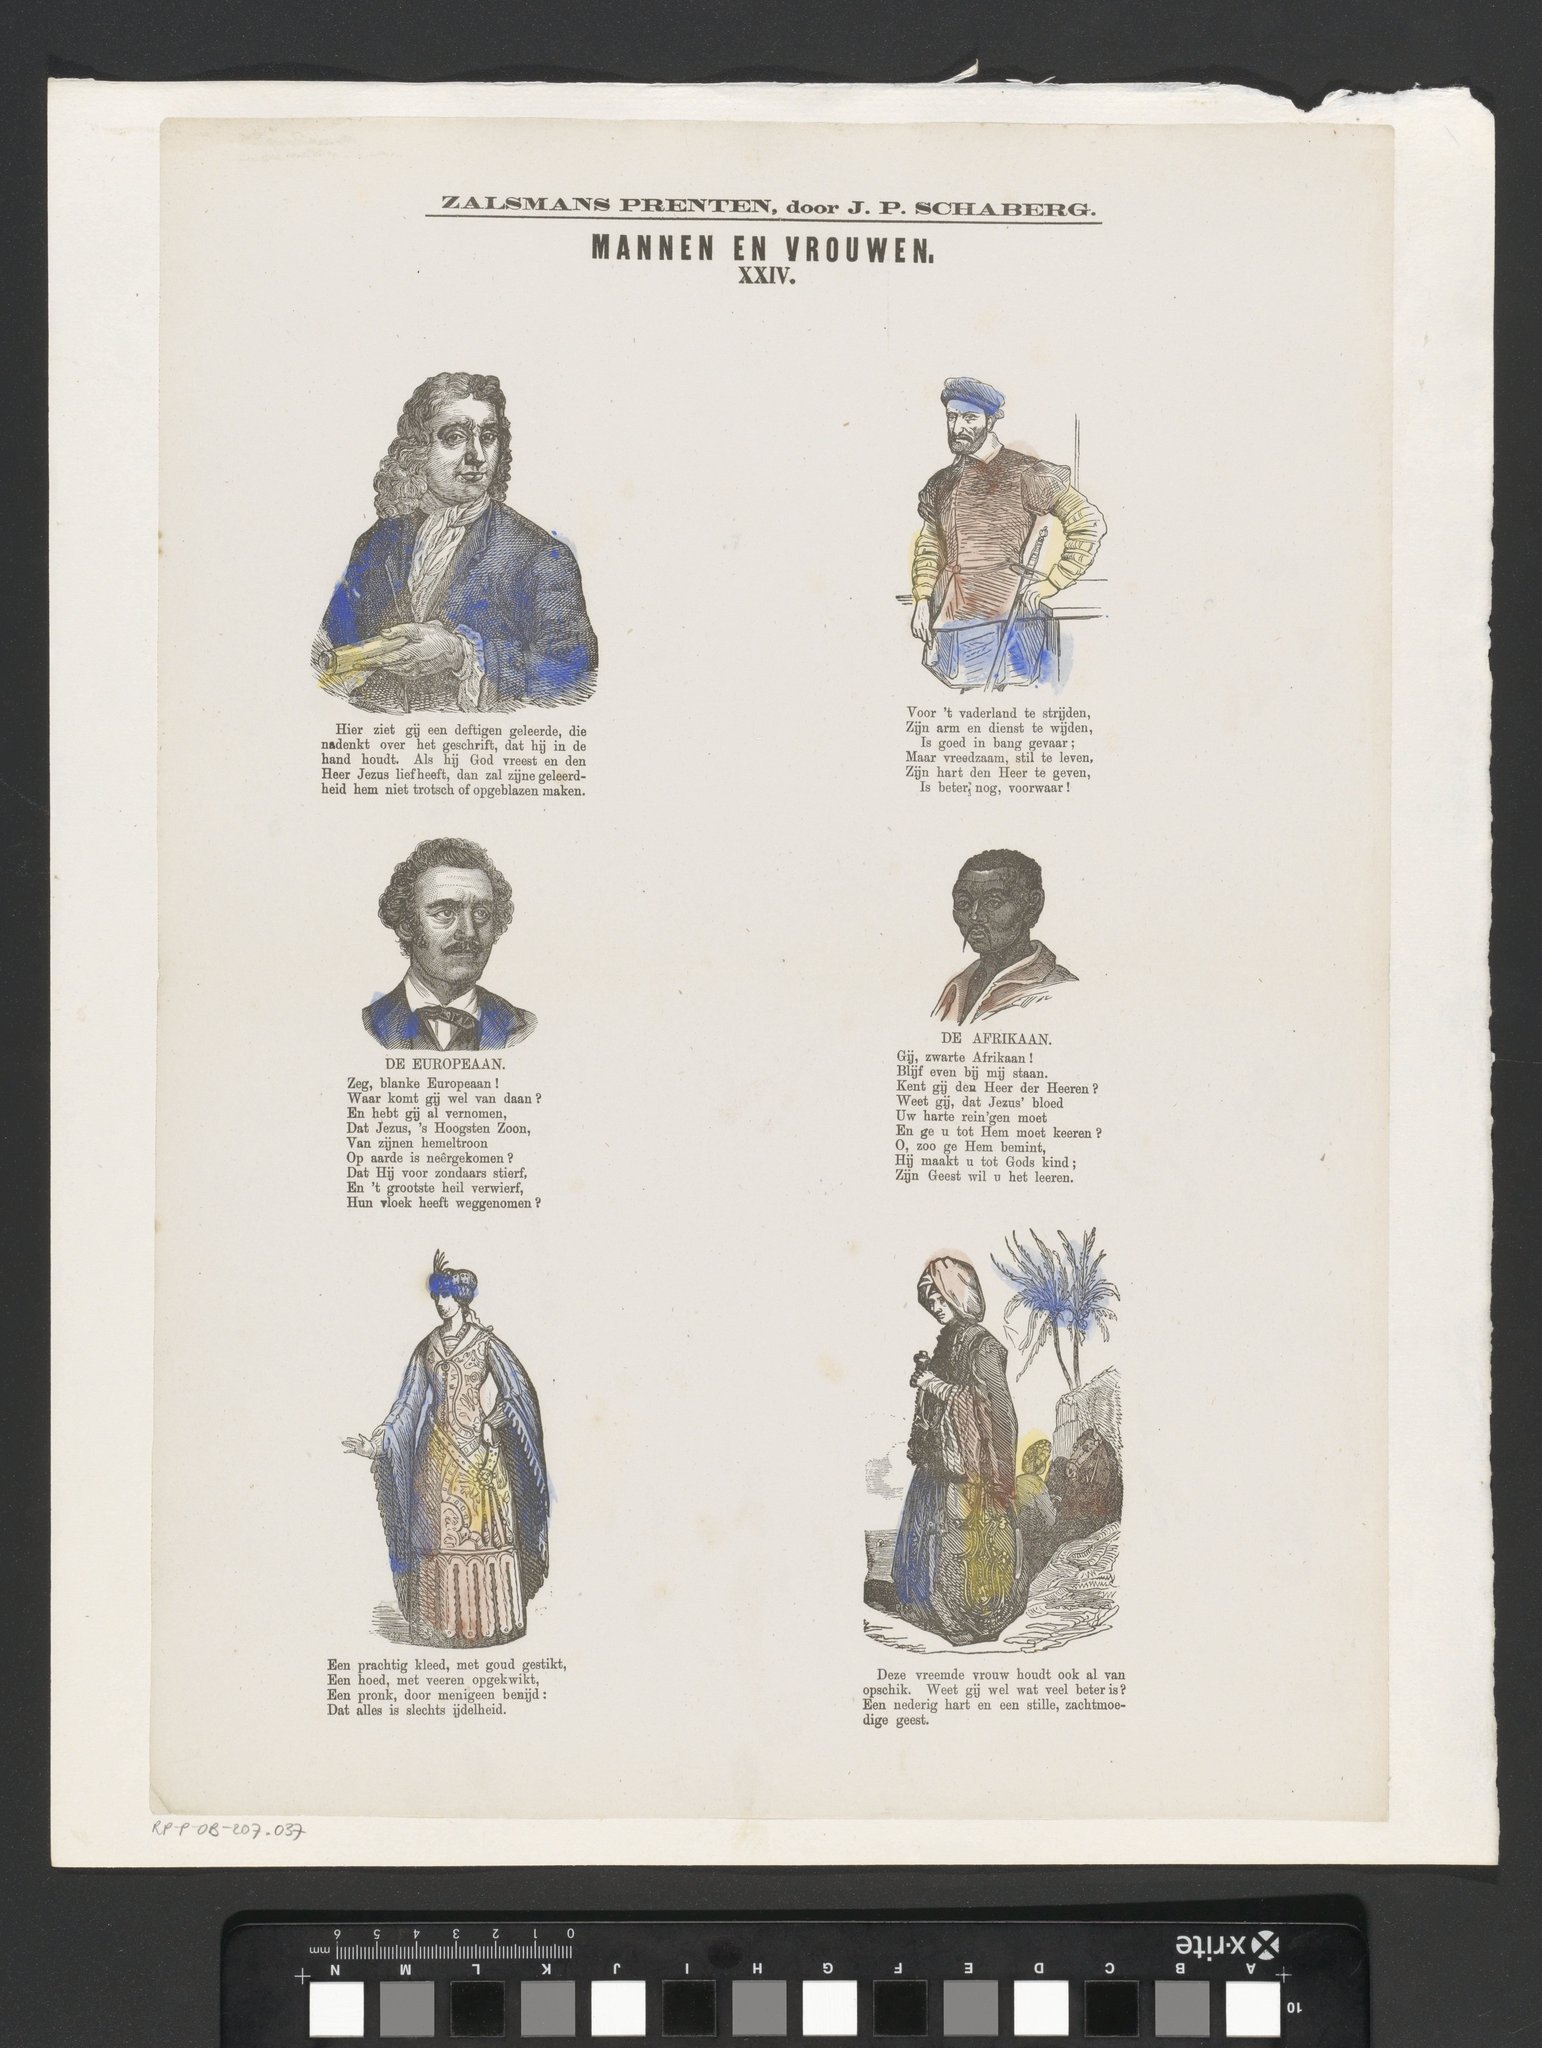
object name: popular print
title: Mannen en vrouwen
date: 1869-1882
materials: paper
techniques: colour, letterpress printing, engraving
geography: kampen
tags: europeans, fashion, clothing, adult woman, human types, africans, adult man, characters (human types)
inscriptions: collector's mark: Lugt 2760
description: Blad met 6 voorstellingen van mannen en vrouwen. Onder elke afbeelding een onderschrift. Genummerd midden boven: XXIV.